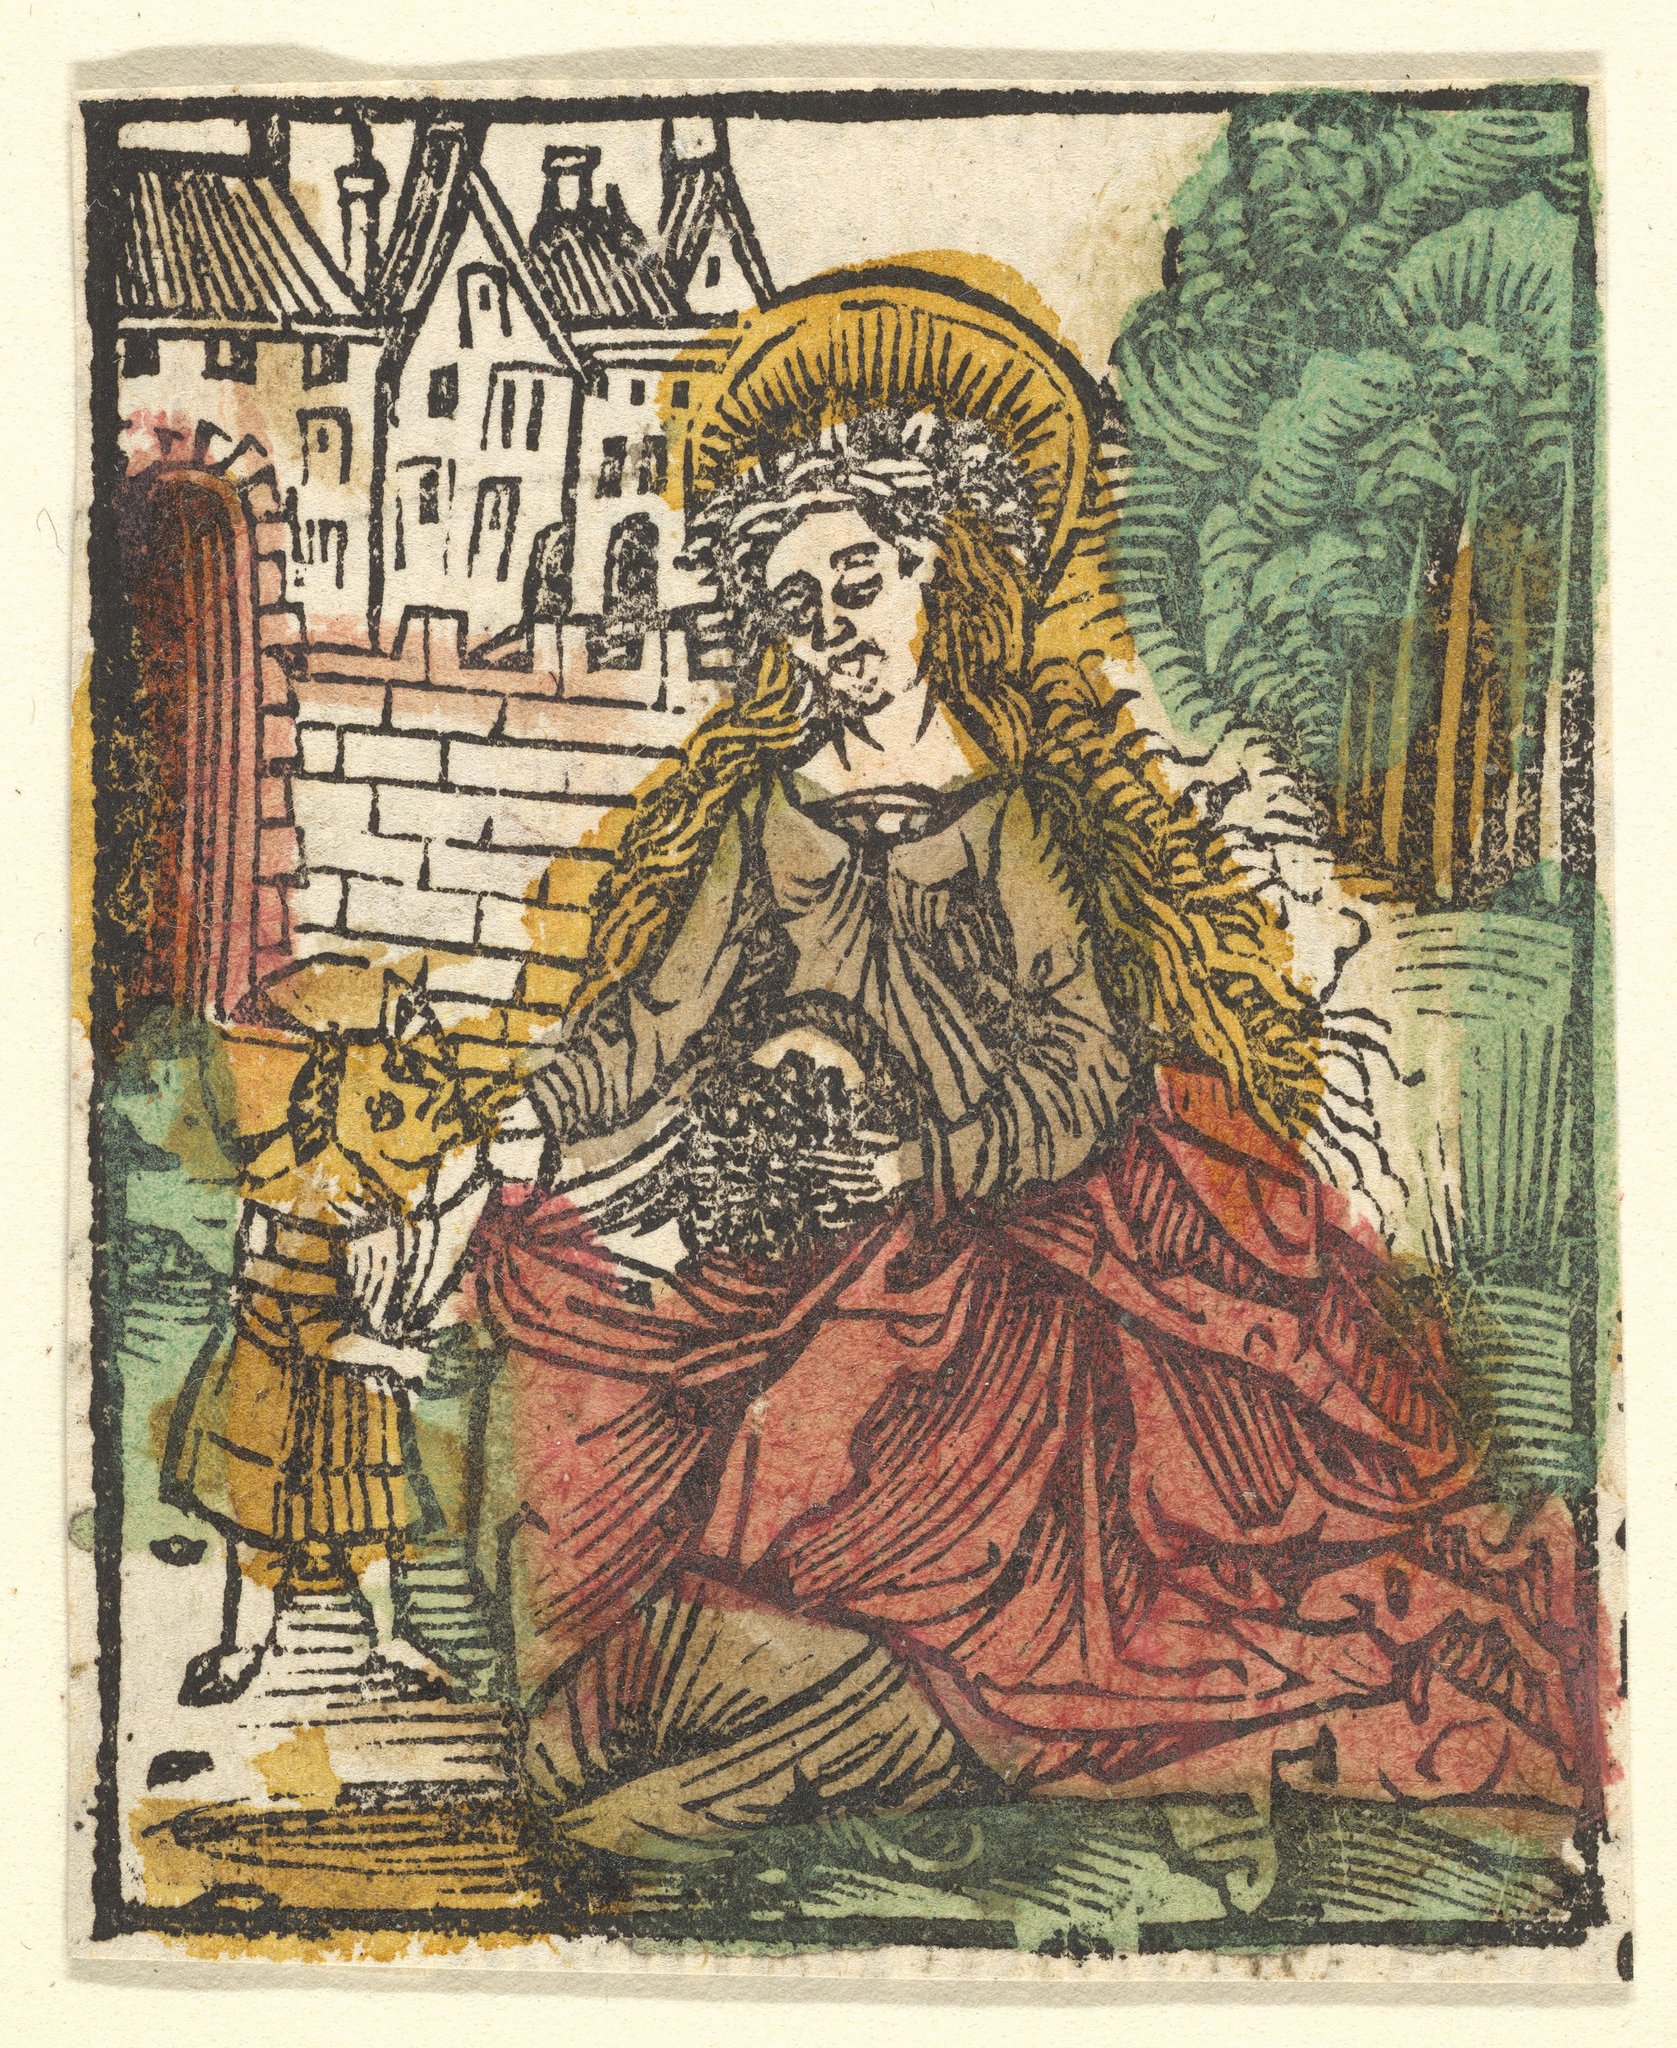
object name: print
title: St. Elizabeth (copy ?)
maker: hans baldung (called hans baldung grien)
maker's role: artist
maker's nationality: german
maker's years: 1484-1545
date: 1512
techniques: hand coloring, woodcut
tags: girls,saints